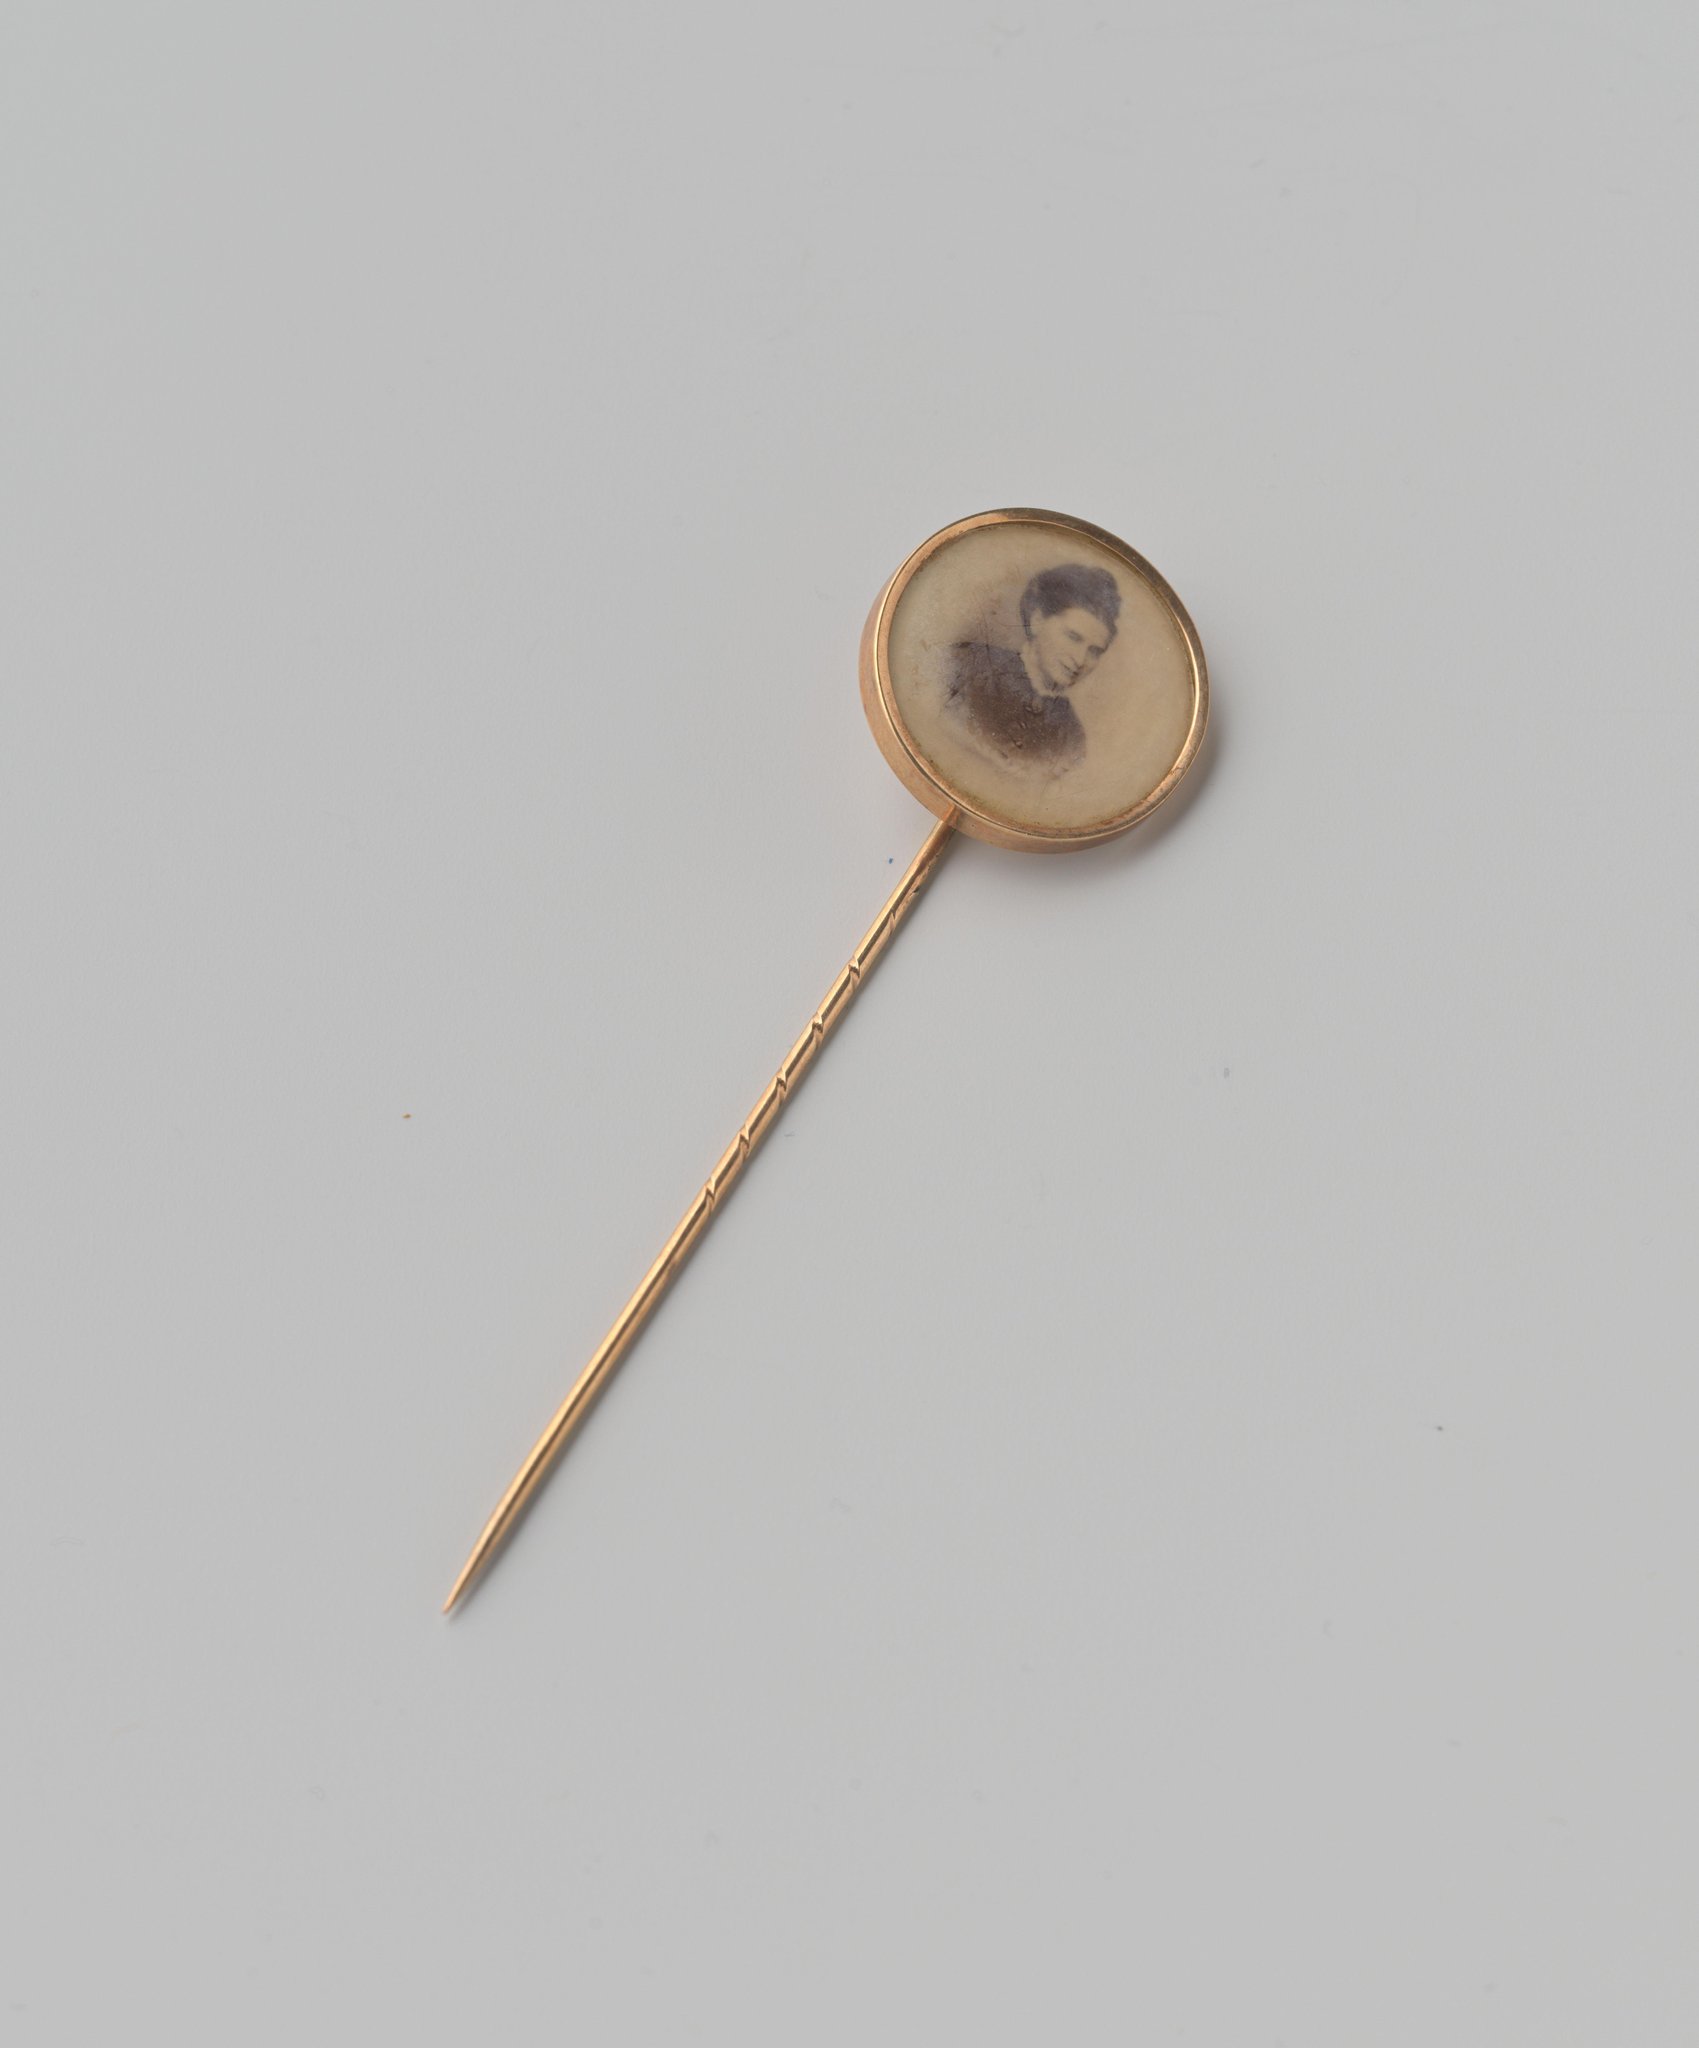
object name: photograph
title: Foto van een dame, gevat in een ronde houder bevestigd aan een pin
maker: Anonymous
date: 1900-1925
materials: metal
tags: eugen wachenheimer, else wachenheimer-moos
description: Dit object is onderdeel van de nalatenschap van Isabel Elon-Wachenheimer (1928-2010). Tot haar overlijden behoorde het samen met de andere objecten uit de nalatenschap tot haar privédomein van Isabel Wachenheimer. In die particuliere context zijn deze objecten tezamen en individueel aandenkens - aan de jeugd, ouders en familie van Isabel Wachenheimer vóór en tijdens de Shoah en aan haar leven na de Tweede Wereldoorlog. Isabel Wachenheimer, die van juni 1943 tot mei 1945 gevangen zat in Kamp Westerbork, Theresienstadt, Auschwitz, Lenzing a/d Oberdonau (een buitenkamp van Mauthausen), overleefde de Shoah. Haar ouders – Eugène Wachenheimer en Else Wachenheimer-Moos - werden op 14 oktober 1944 in Auschwitz-Birkenau vermoord.